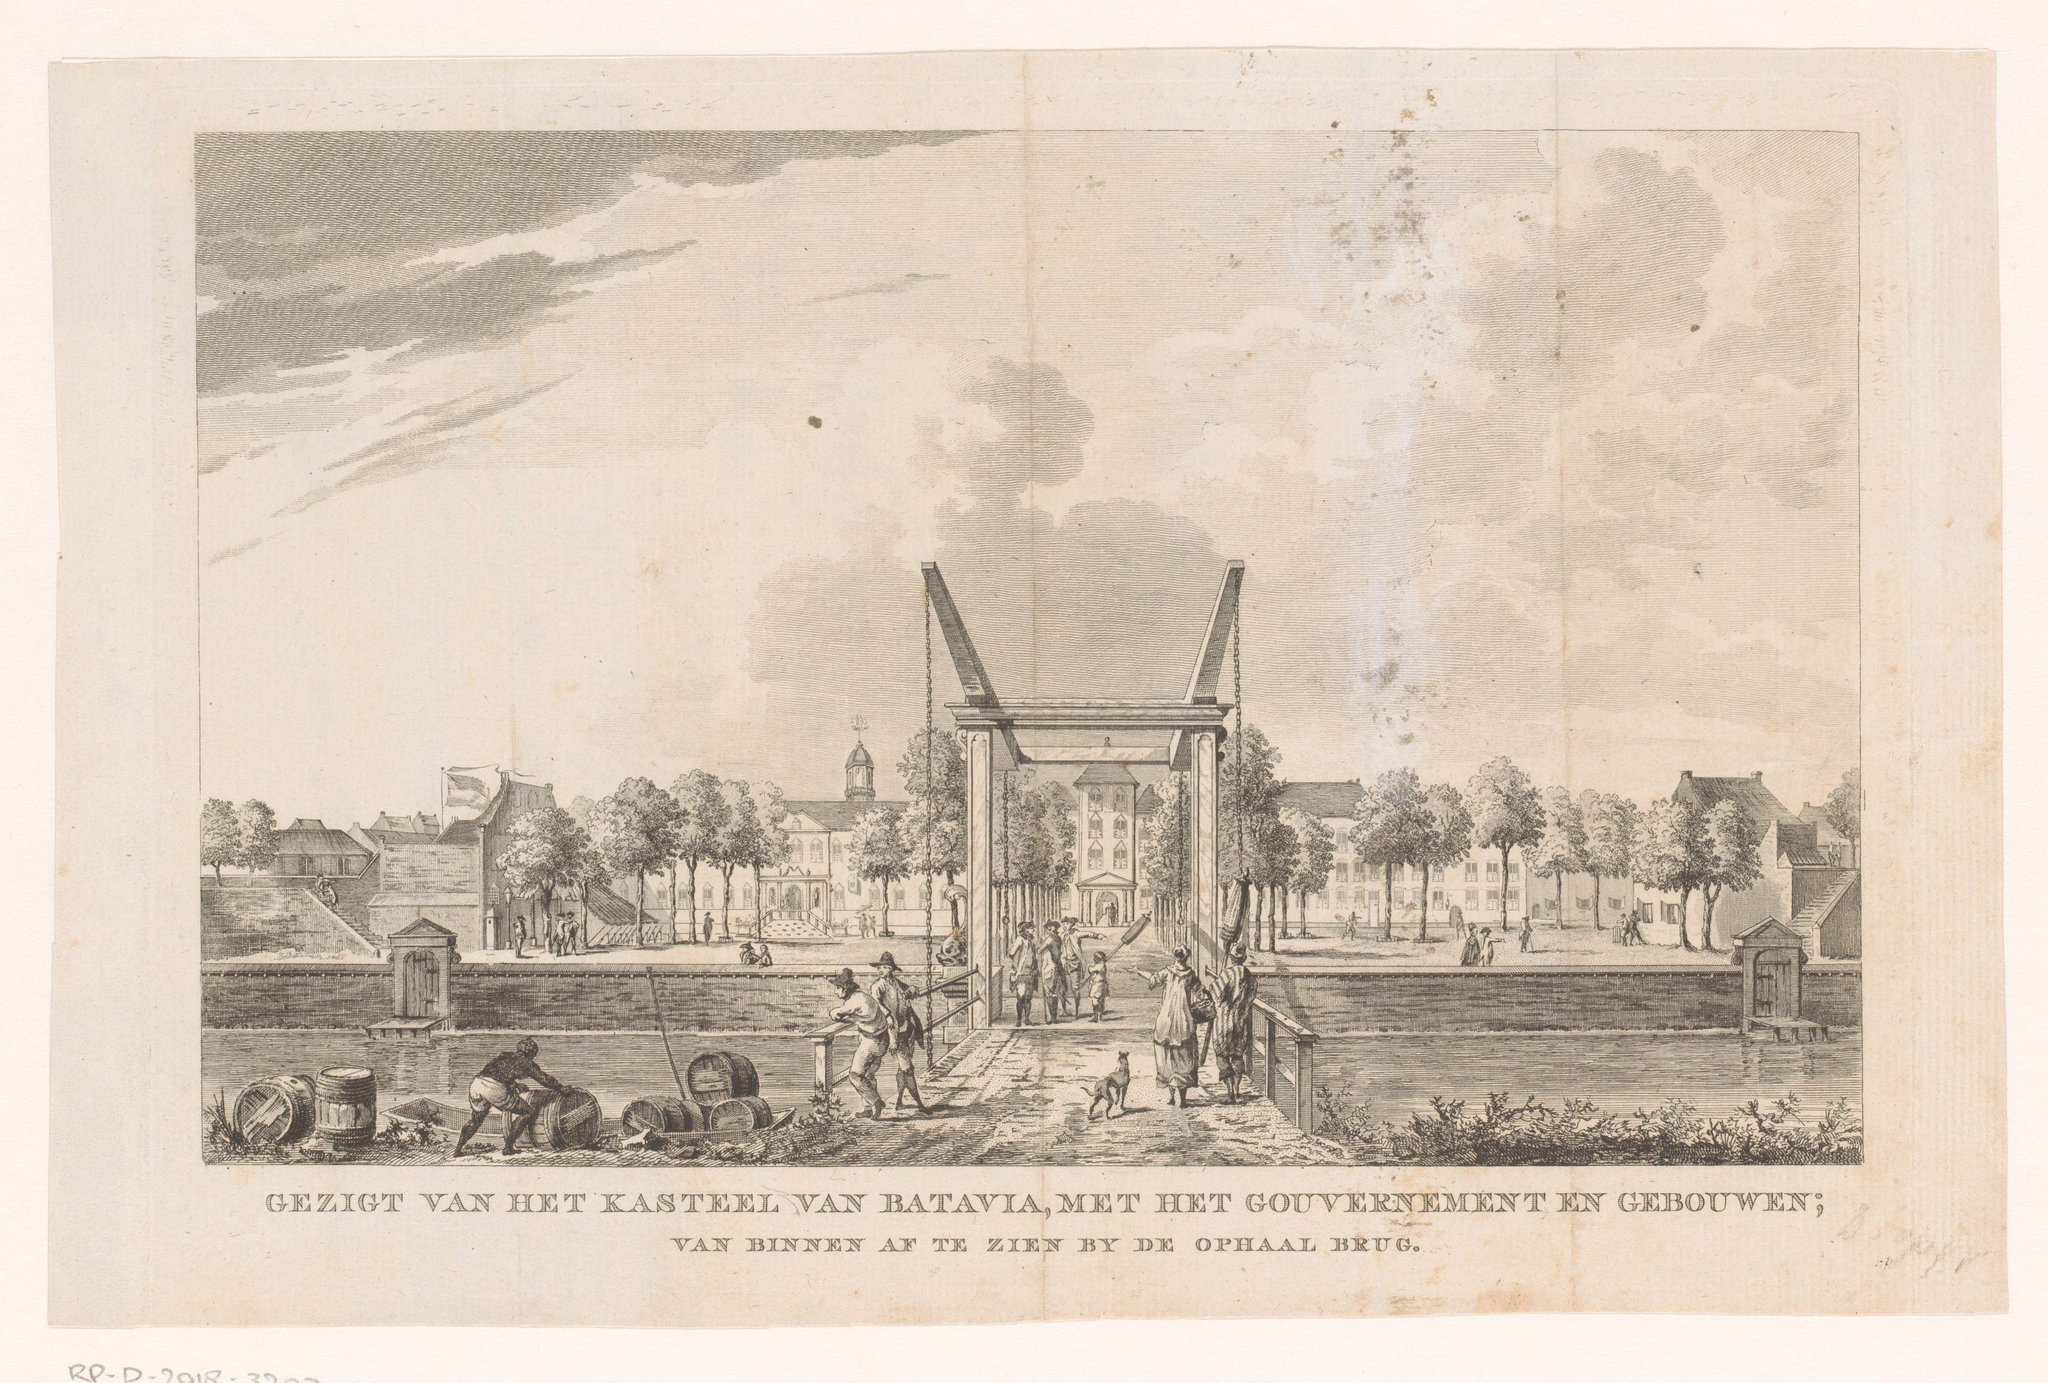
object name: book illustration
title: Gezigt van het kasteel van Batavia, met het gouvernement en gebouwen; van binnen af te zien by de ophaal brug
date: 1781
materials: paper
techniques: engraving, etching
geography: rotterdam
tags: drawbridge ~ fortified city, bascule bridge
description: Mogelijk naar de tekening door Hendrik Kobell, coll. Rijksmuseum RP-T-FM-74. Prent uit: Verhandelingen van het Bataviaasch Genootschap der Kunsten en Wetenschappen. 61 dln. Rotterdam en Amsterdam: Reinier Arrenberg en Johannes Allart, 1781, dl. 1, p. 48.